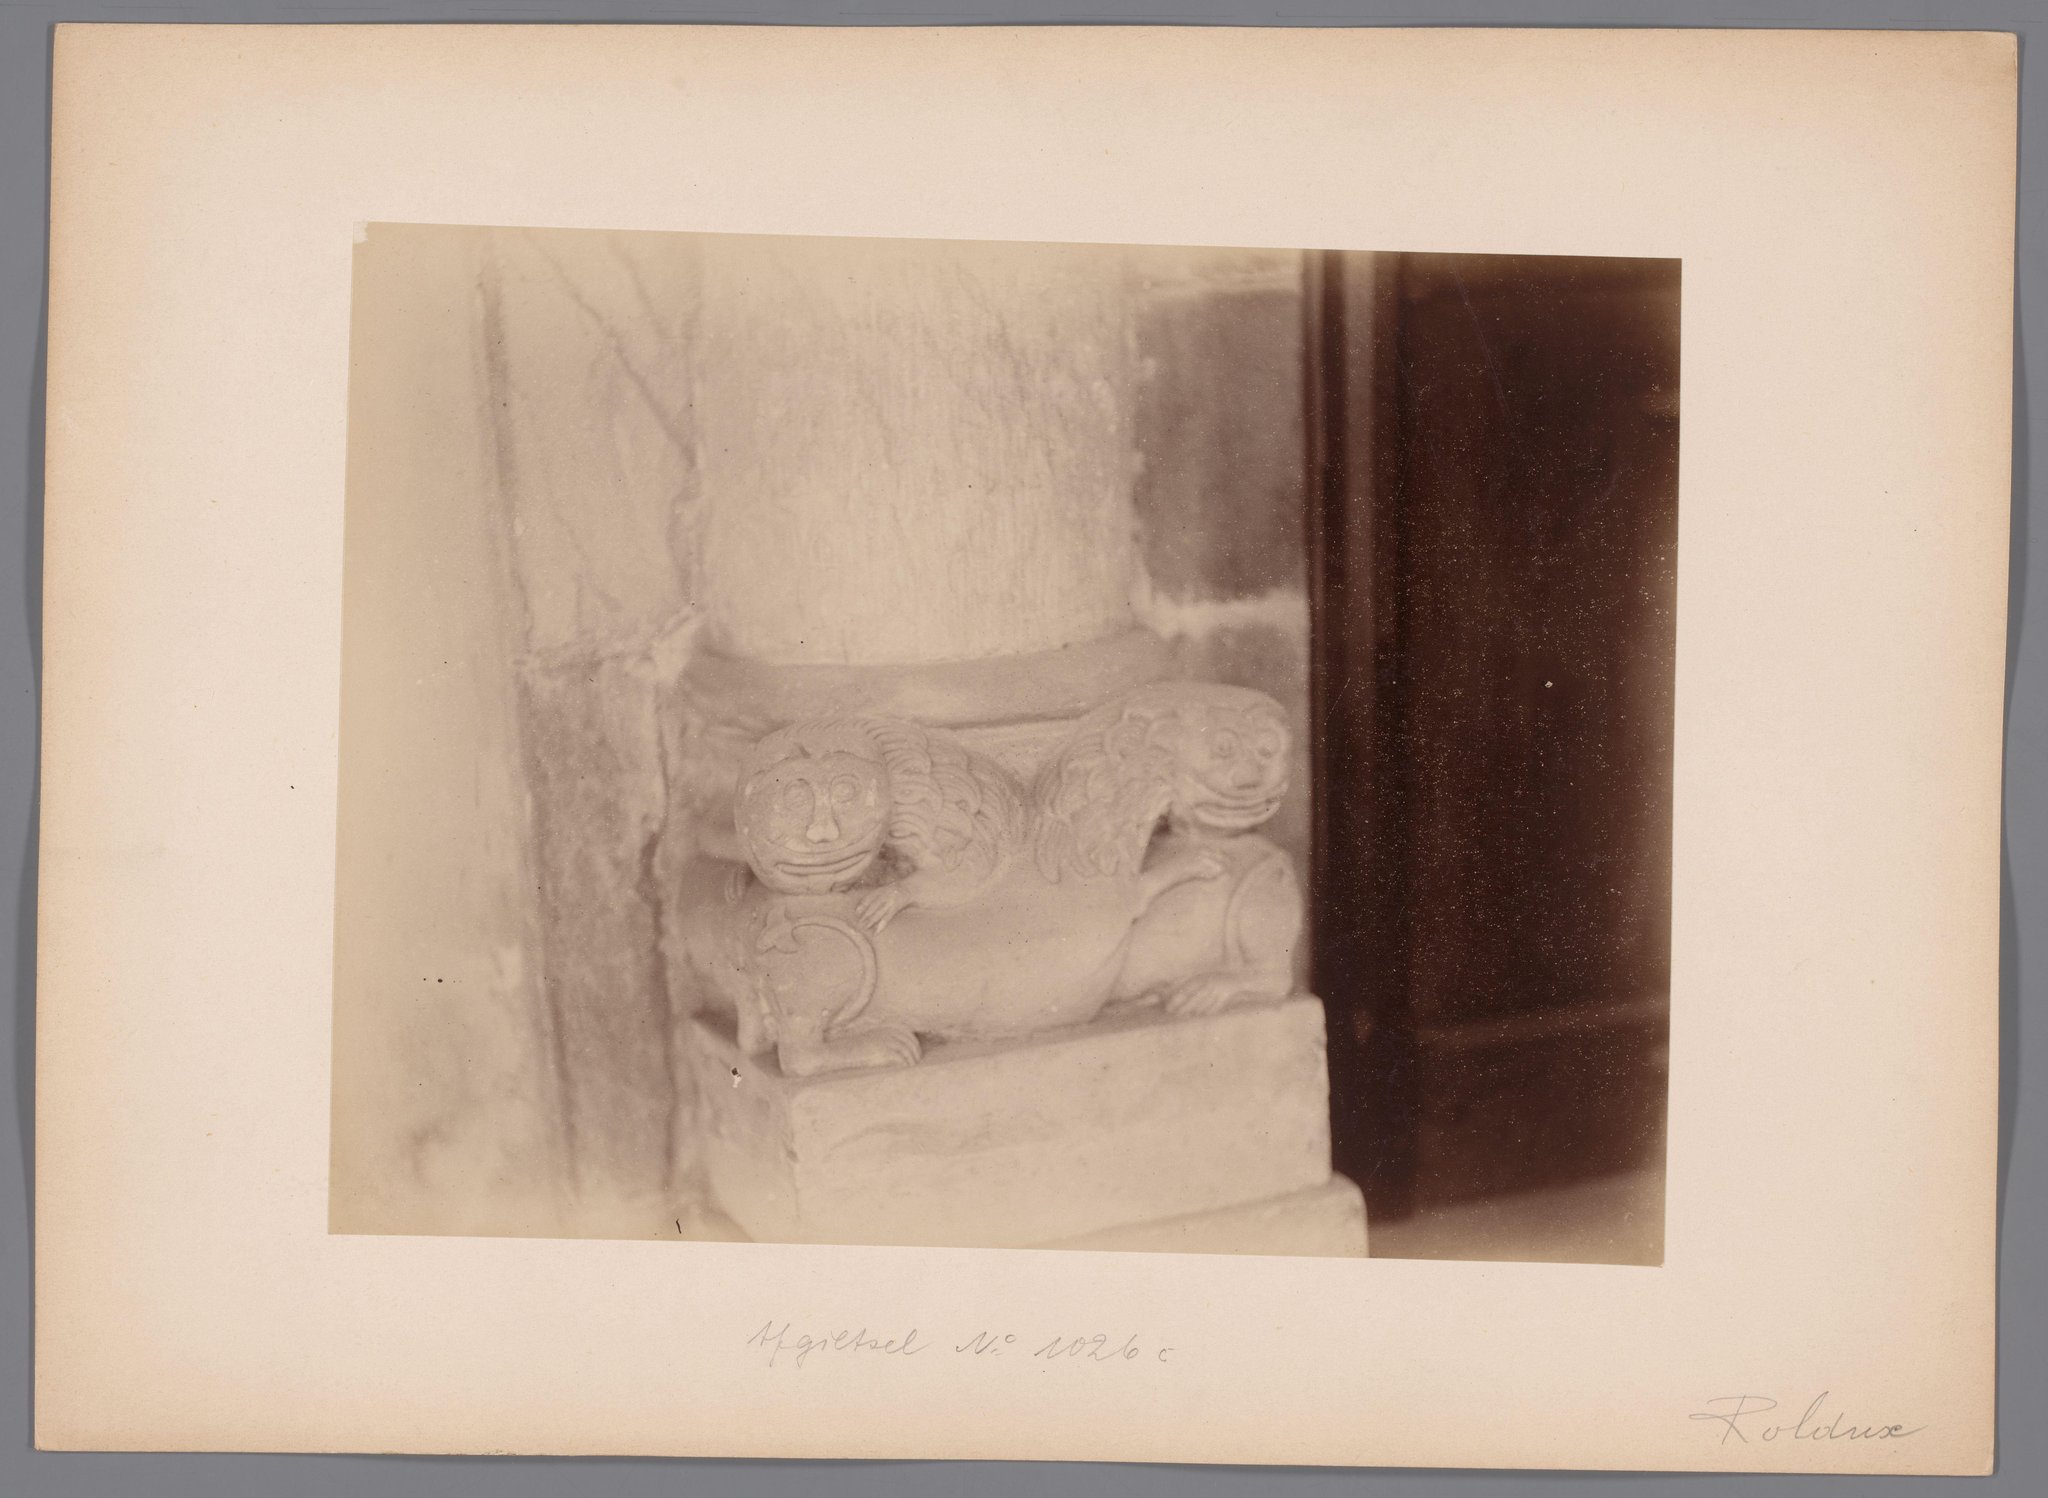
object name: photograph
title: Basement van een wandkolom in de Abdijkerk te Rolduc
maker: anoniem (monumentenzorg)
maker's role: fotograaf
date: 1890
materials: cardboard, photographic support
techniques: albumen print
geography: rolduc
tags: base (~ column, pillar)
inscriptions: annotation: ‘Afgietsel No. 1026 c/ Rolduc’, annotation: ‘Basement van een der wandkolommen in de kerk te Rolduc/ oct 1980’